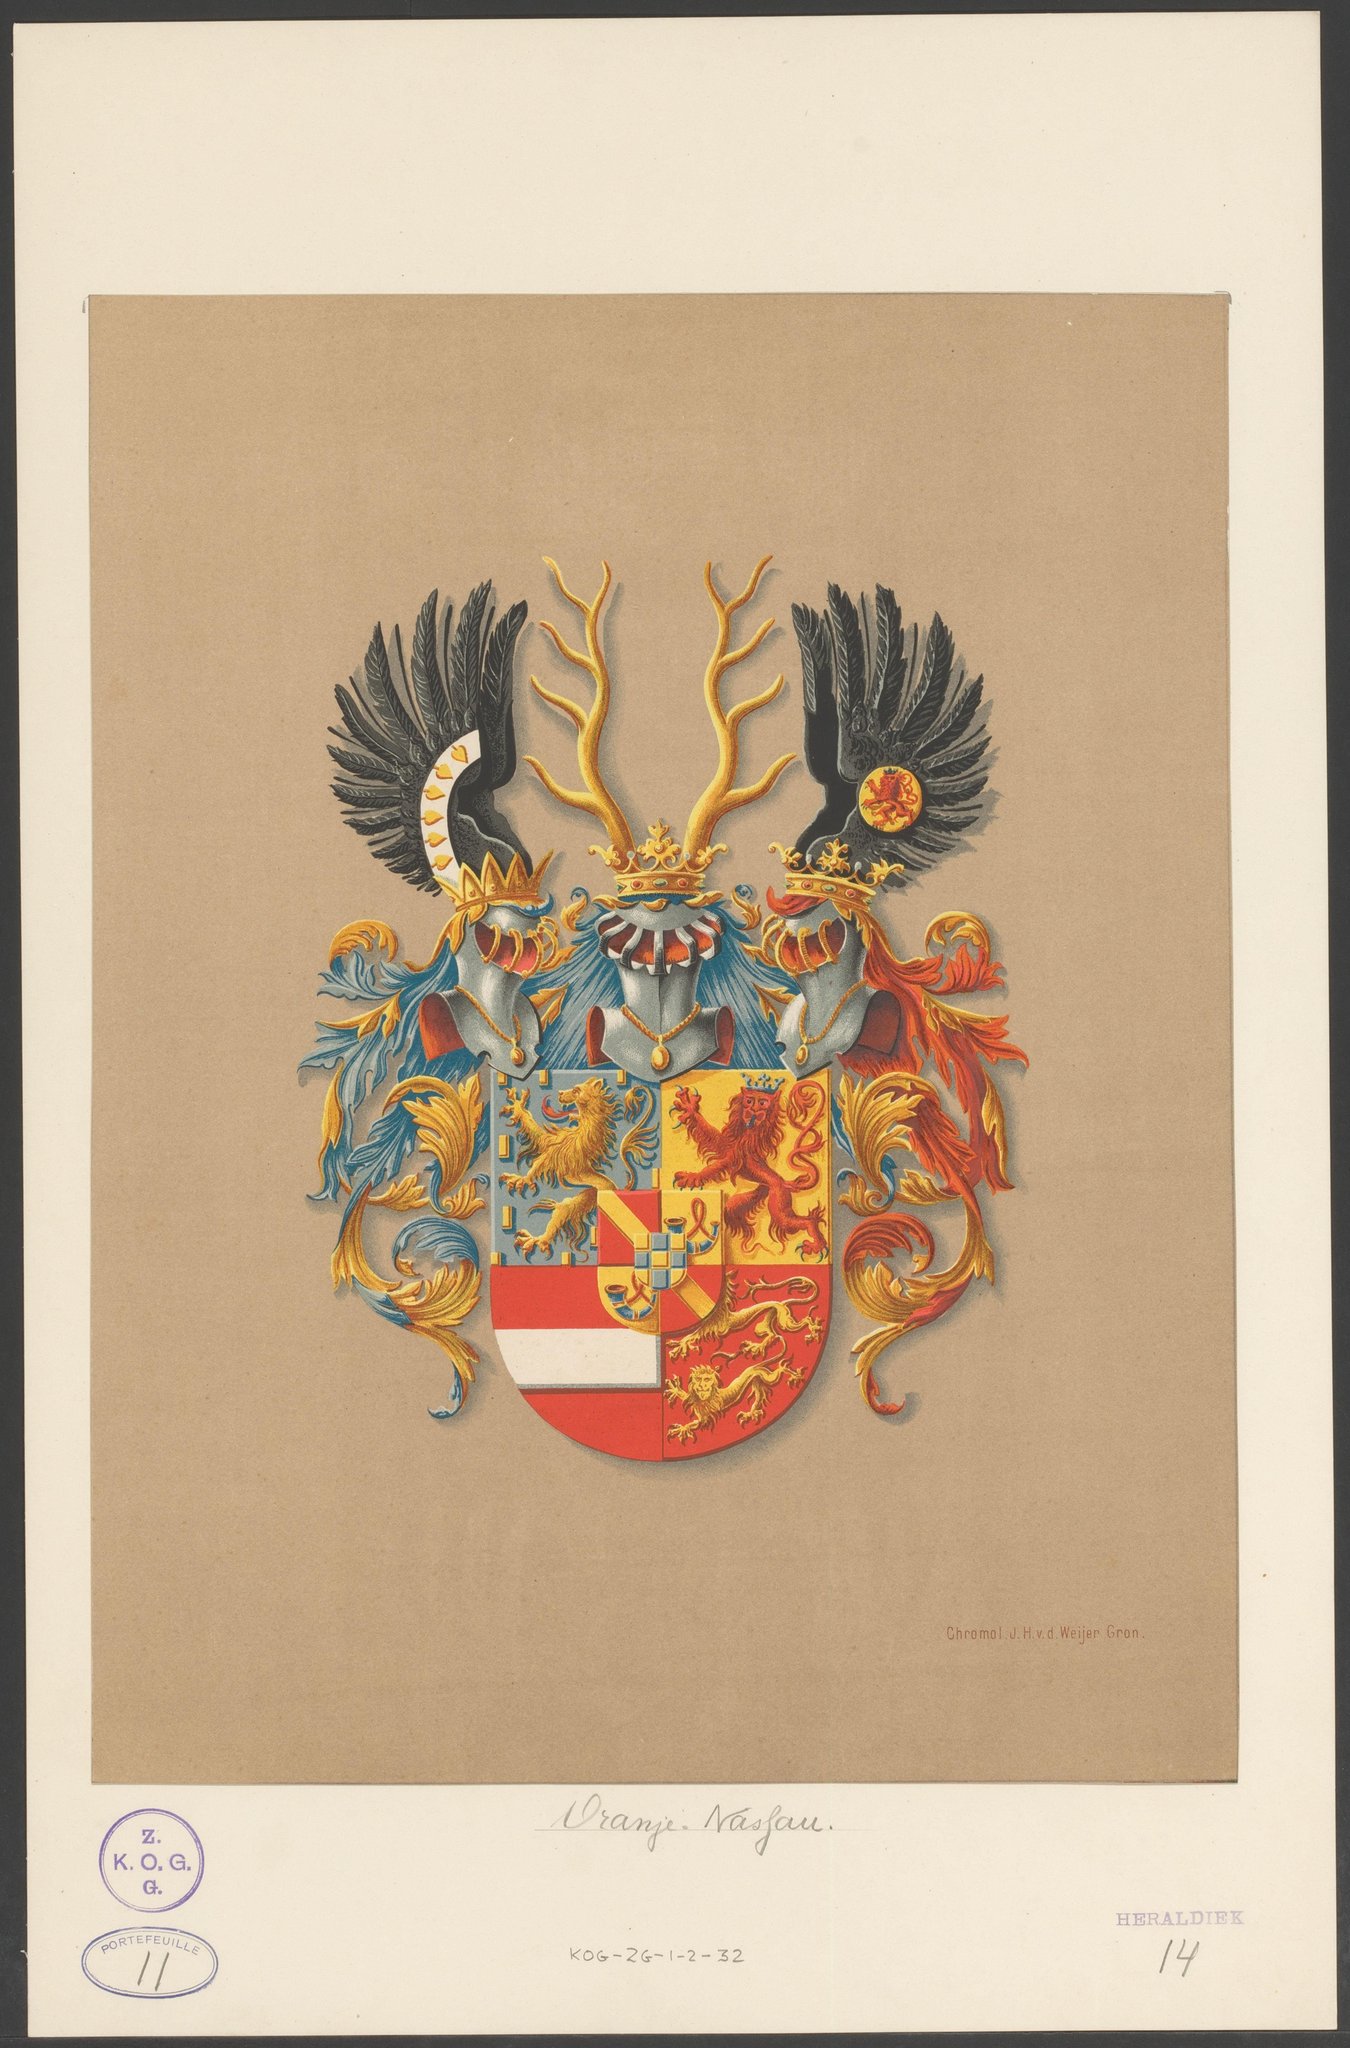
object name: print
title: Wapen van Oranje-Nassau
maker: johannes hermanus van de weijer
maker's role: print maker, printer, publisher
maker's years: 1817-1889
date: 1840-1876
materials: paper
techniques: chromolithography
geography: groningen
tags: armorial bearing, heraldry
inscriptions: collector's mark: Lugt 1641, collector's mark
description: Wapen van Oranje-Nassau. Vier kwartieren met hartschild en drie helmen, zonder schildhouders. Onderwerpsrubrieken binnen de Atlas Zeden en Gewoonten: Regeering, Wapens (Heraldiek), Wapens van Regeerende Huizen.